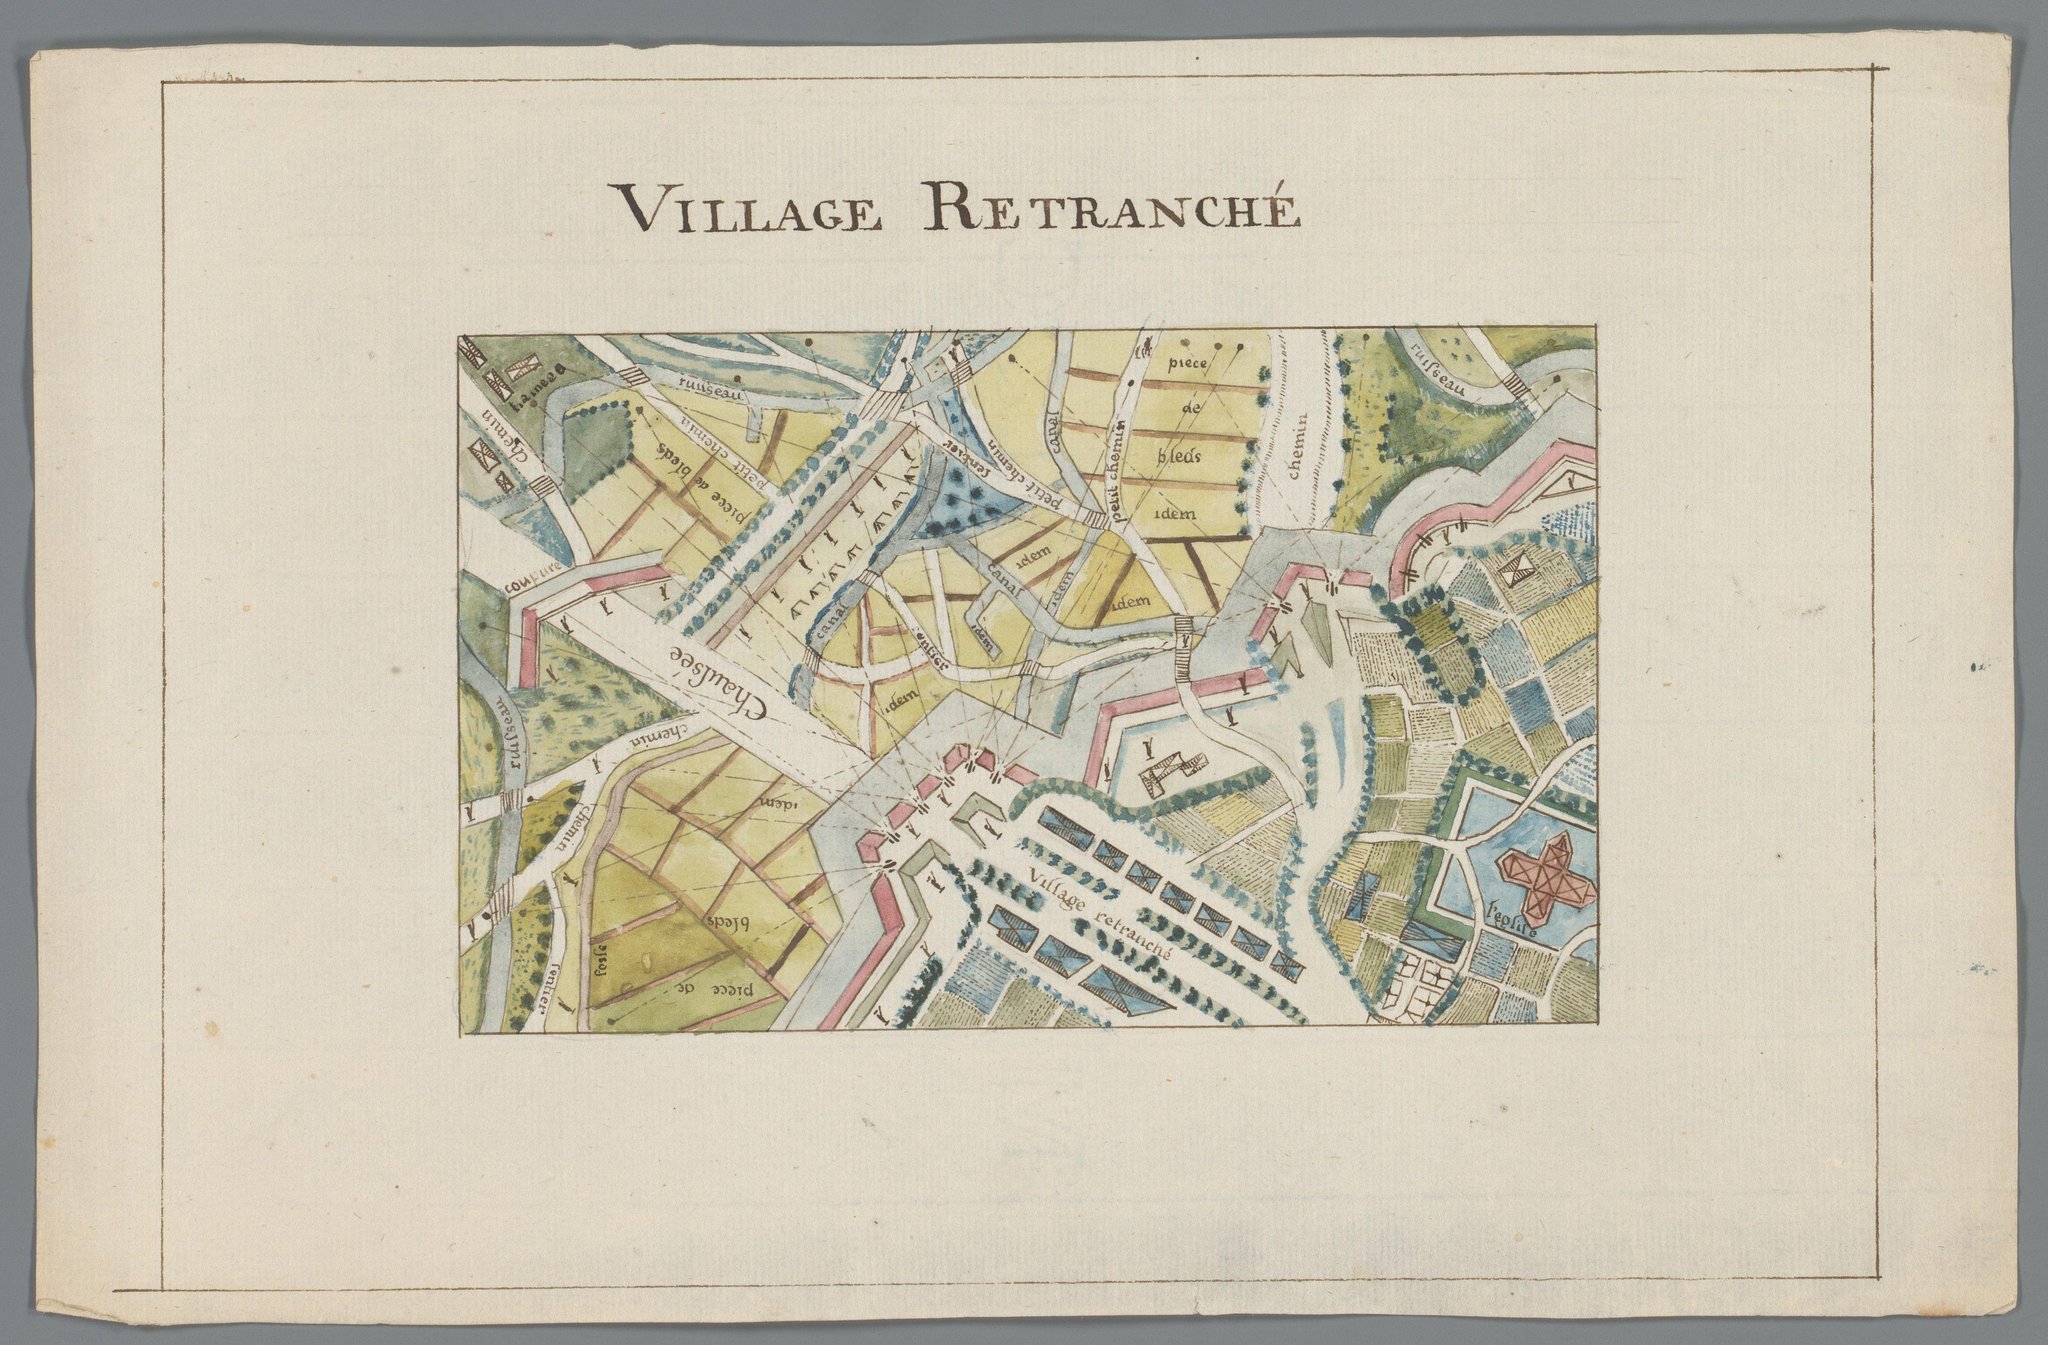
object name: drawing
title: Village Retranché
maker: hendrik van der poth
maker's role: draughtsman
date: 1795-1803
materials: paper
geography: netherlands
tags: fortified city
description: Strategische tekening over het oprichten van fortificaties rond een dorp, ca. 1799.